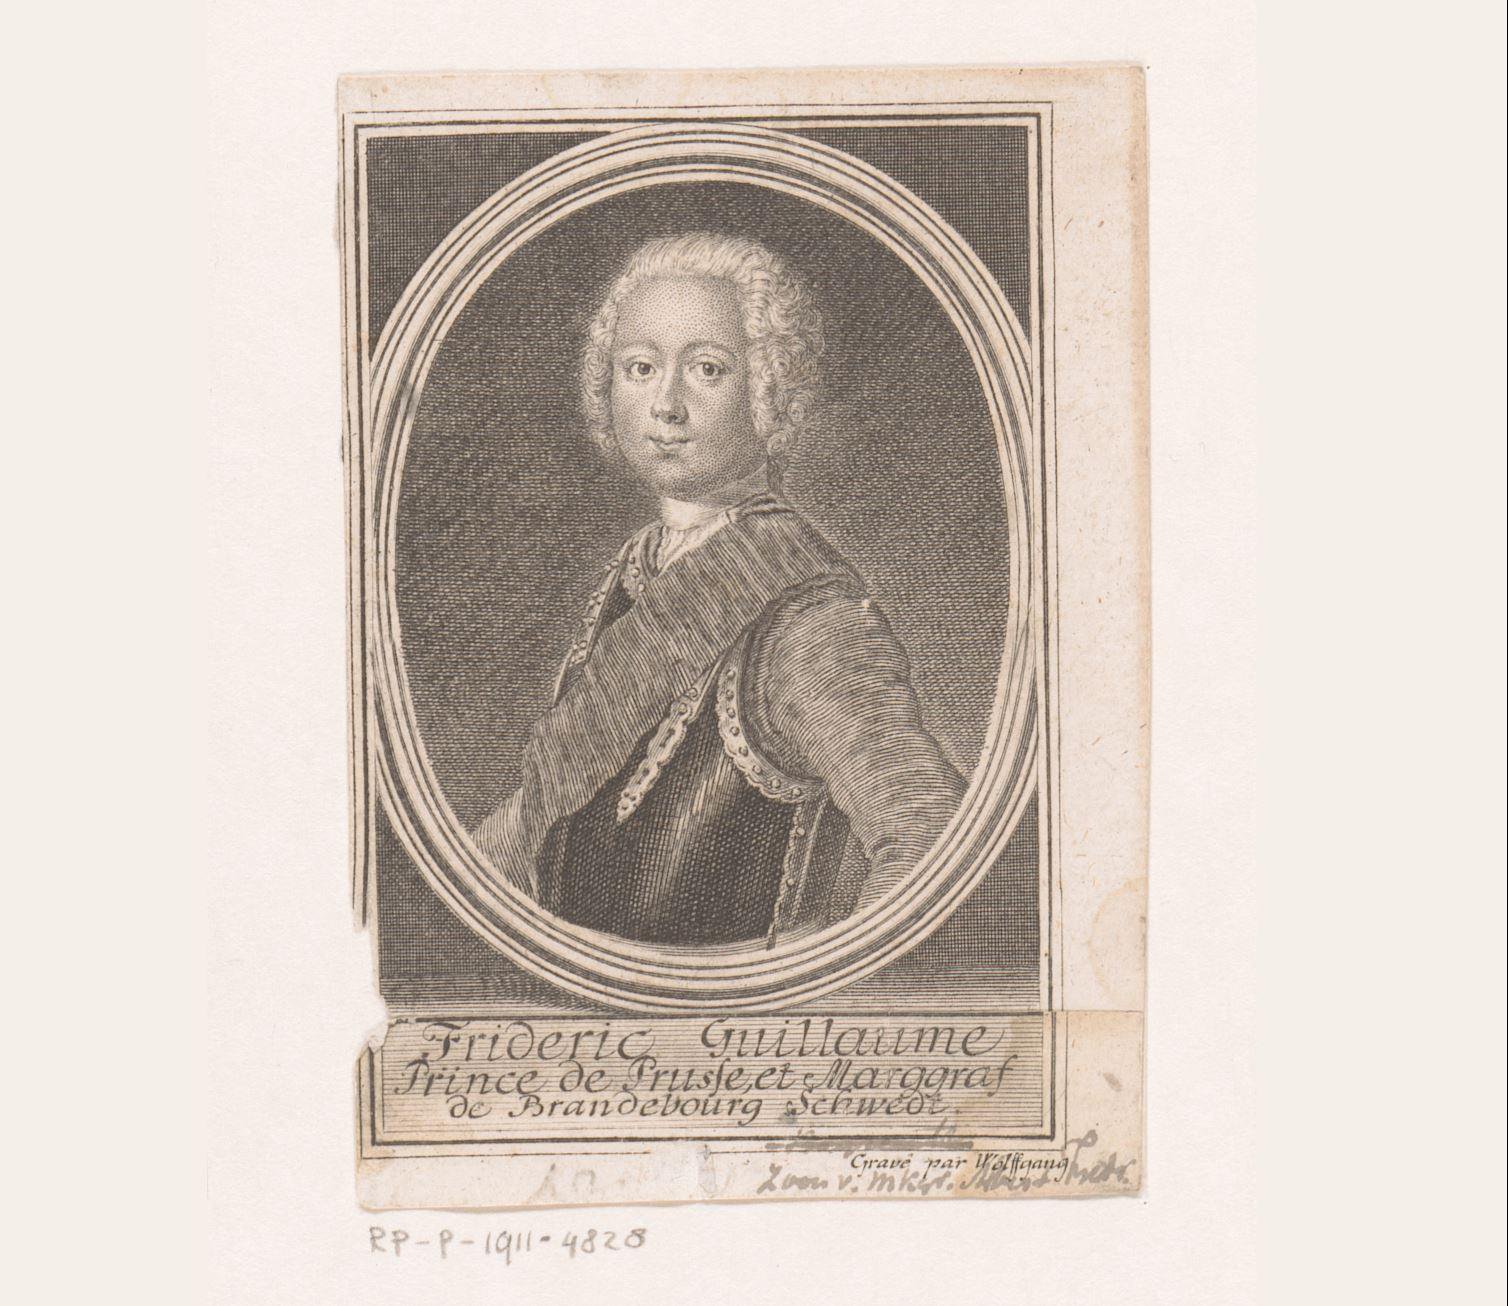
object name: print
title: Portret van Friedrich Wilhelm, Markgraf von Brandenburg-Schwedt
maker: gustav andreas wolfgang (1692-1775)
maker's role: print maker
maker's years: 1692-1775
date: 1720-1775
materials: paper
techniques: engraving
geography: germany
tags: poland, historical persons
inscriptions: collector's mark: Lugt 2228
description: Twee aan elkaar gemonteerde bladen (portret en onderschrift).